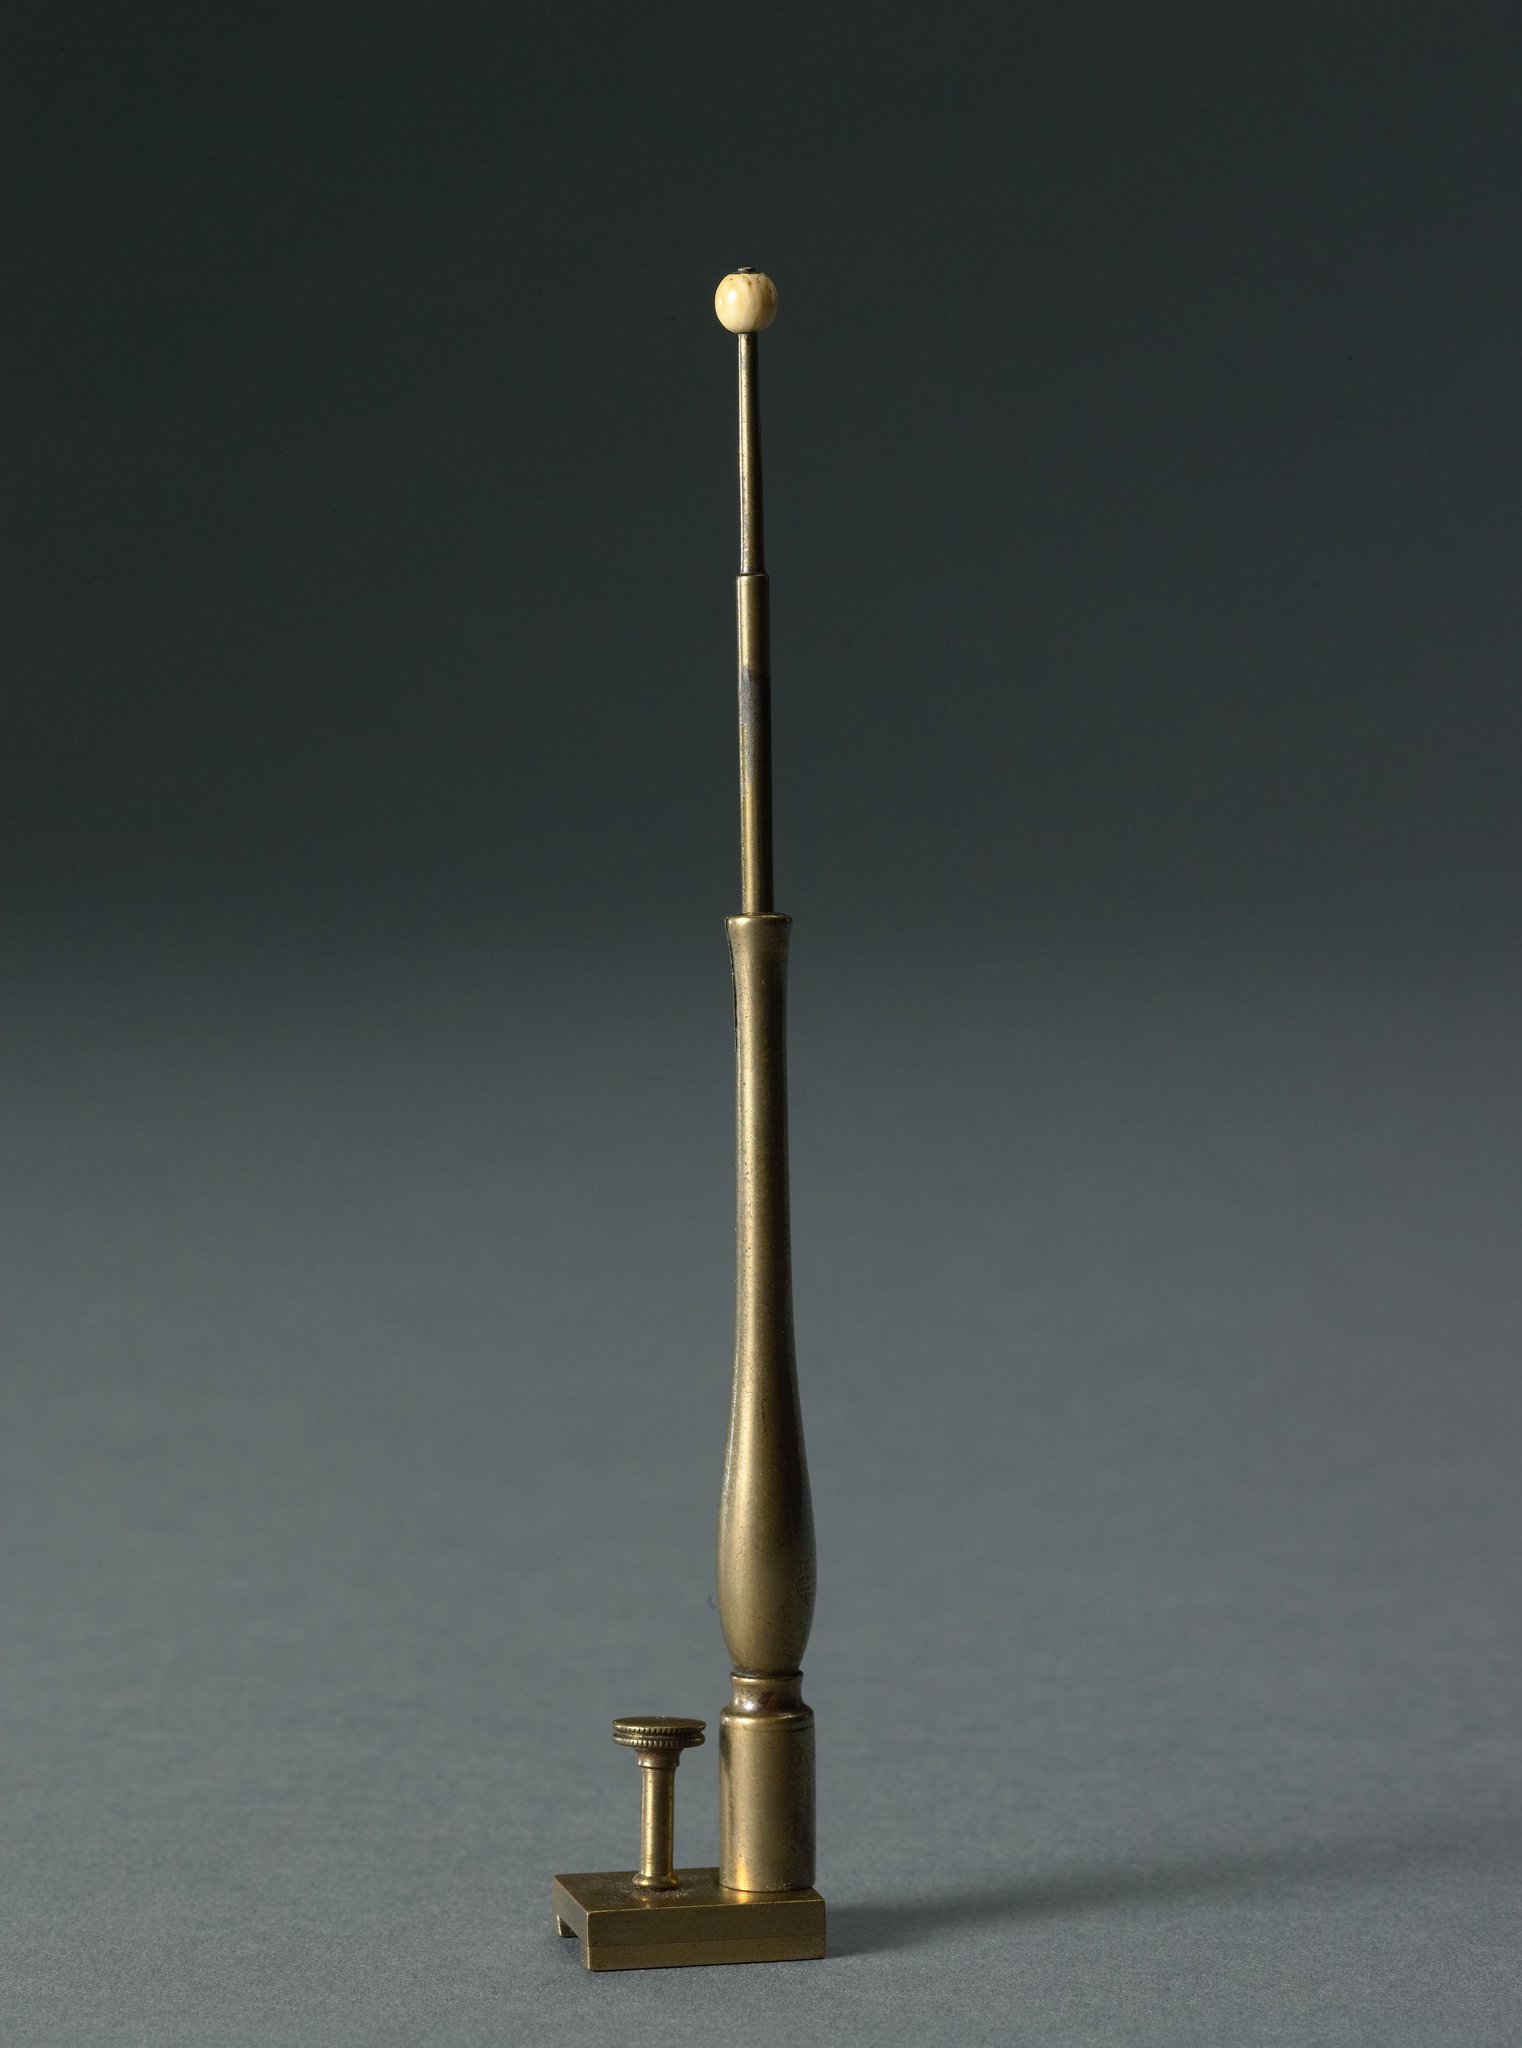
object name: orrery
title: Het statief met de maan, onderdeel van het planetarium, tellurium, lunarium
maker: hartog van laun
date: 1800-1808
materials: brass, ivory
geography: amsterdam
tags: amsterdam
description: Toestel waarmee de beweging van zon, aarde, maan en planeten aanschouwelijk kan worden voorgesteld. Statief waarop een kleine ivoren bol (de maan) met onderaan een verbindingsstuk (zwaluwstaart) met draaiknop.